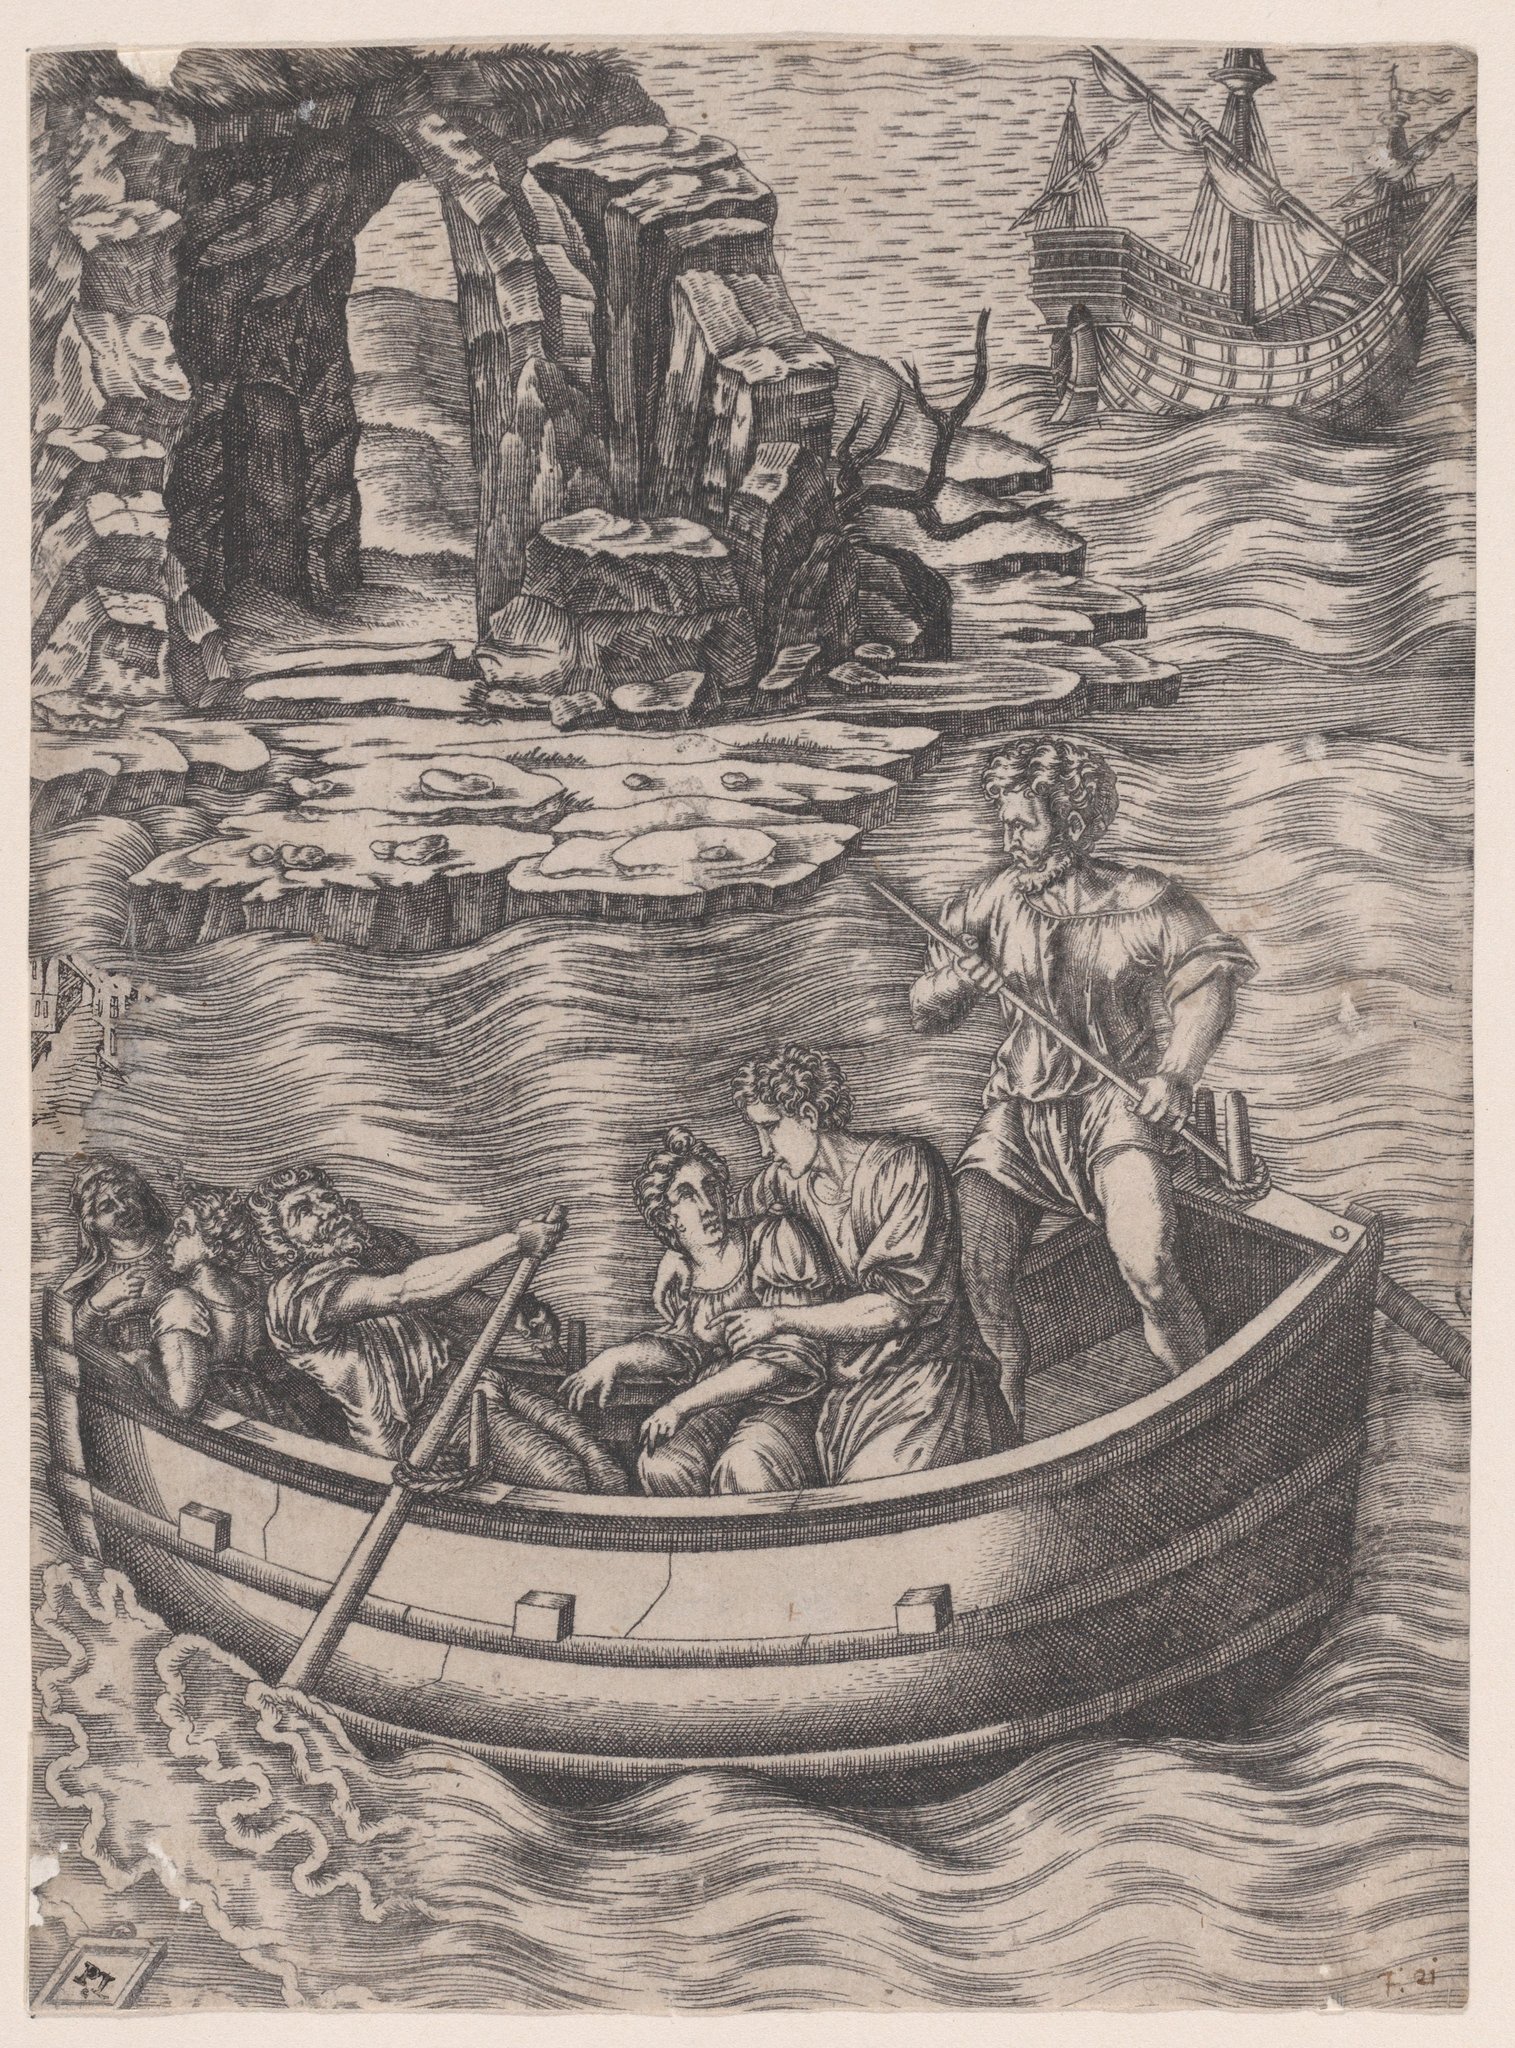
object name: print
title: The Bark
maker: agostino veneziano (agostino dei musi)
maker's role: artist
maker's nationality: italian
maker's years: 1490-1536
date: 1514-1536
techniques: engraving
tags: men,women,boats